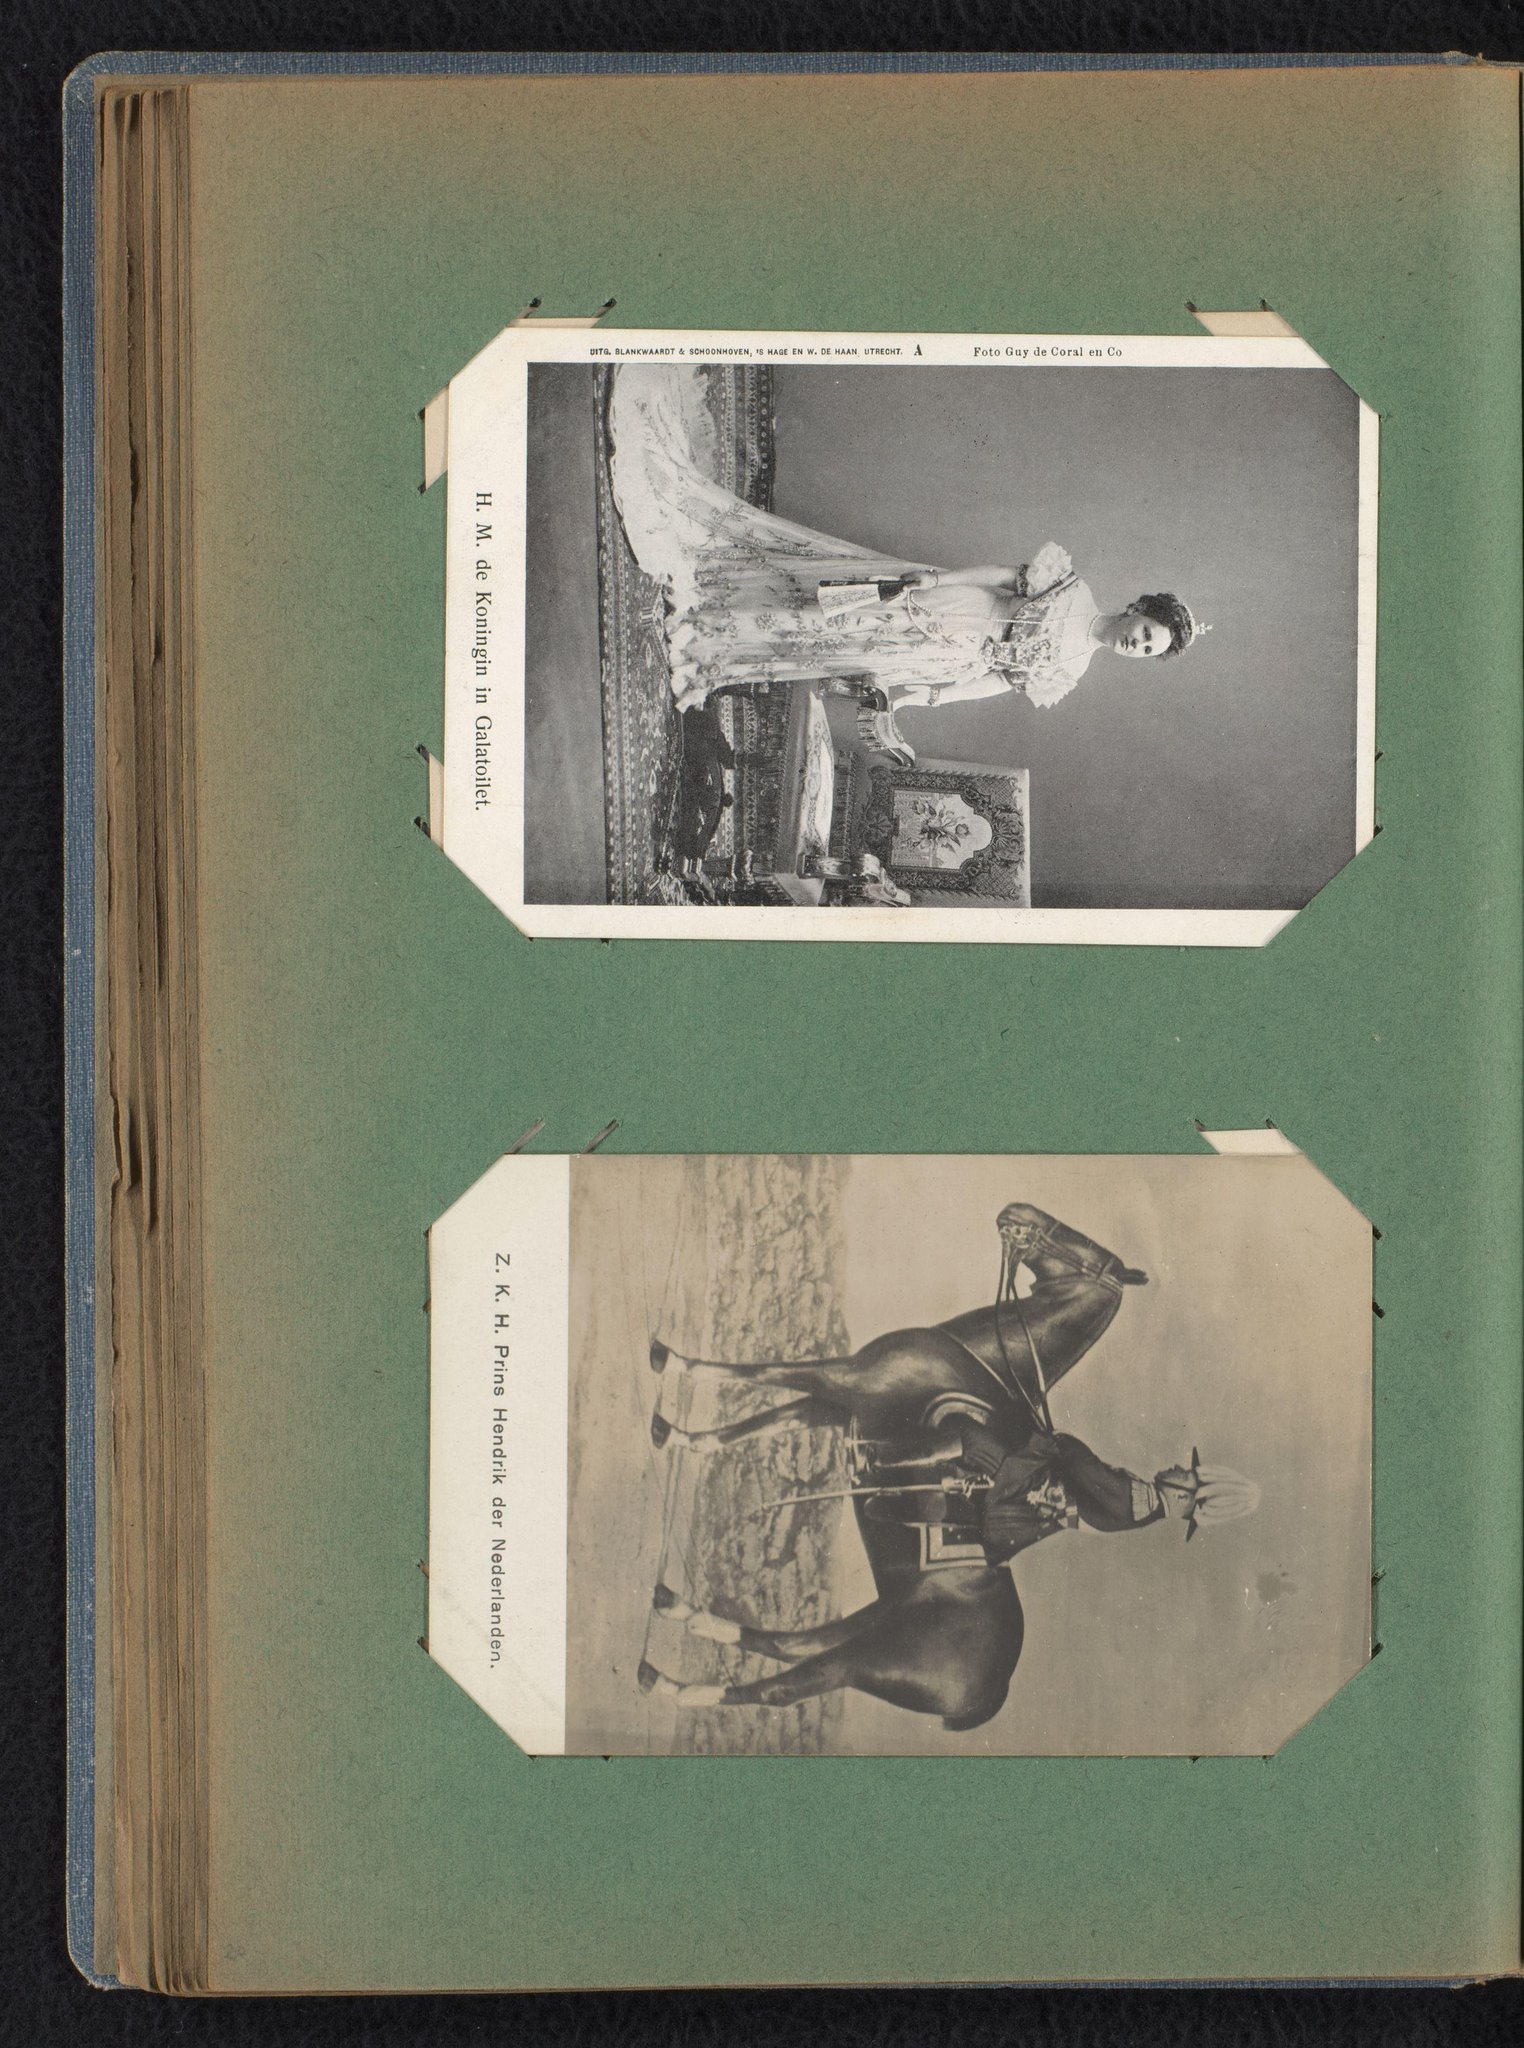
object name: photomechanical print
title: Twee prentbriefkaarten met portretten van koningin Wilhelmina en prins Hendrik te paard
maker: Anonymous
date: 1905-1915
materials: paper, cardboard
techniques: gelatin silver print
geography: netherlands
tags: print maker, wilhelmina of the netherlands, the hague, hendrik (prins der nederlanden (1876-1934)), riding a horse, ass, or mule; rider, horseman, historical persons - bb - woman, historical persons, queen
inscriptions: inscription: ‘H.M. de Koningin in Galatoilet.’, inscription: ‘Z.K.H. Prins Hendrik der Nederlanden.’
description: Deze foto en prent maken deel uit van een album.